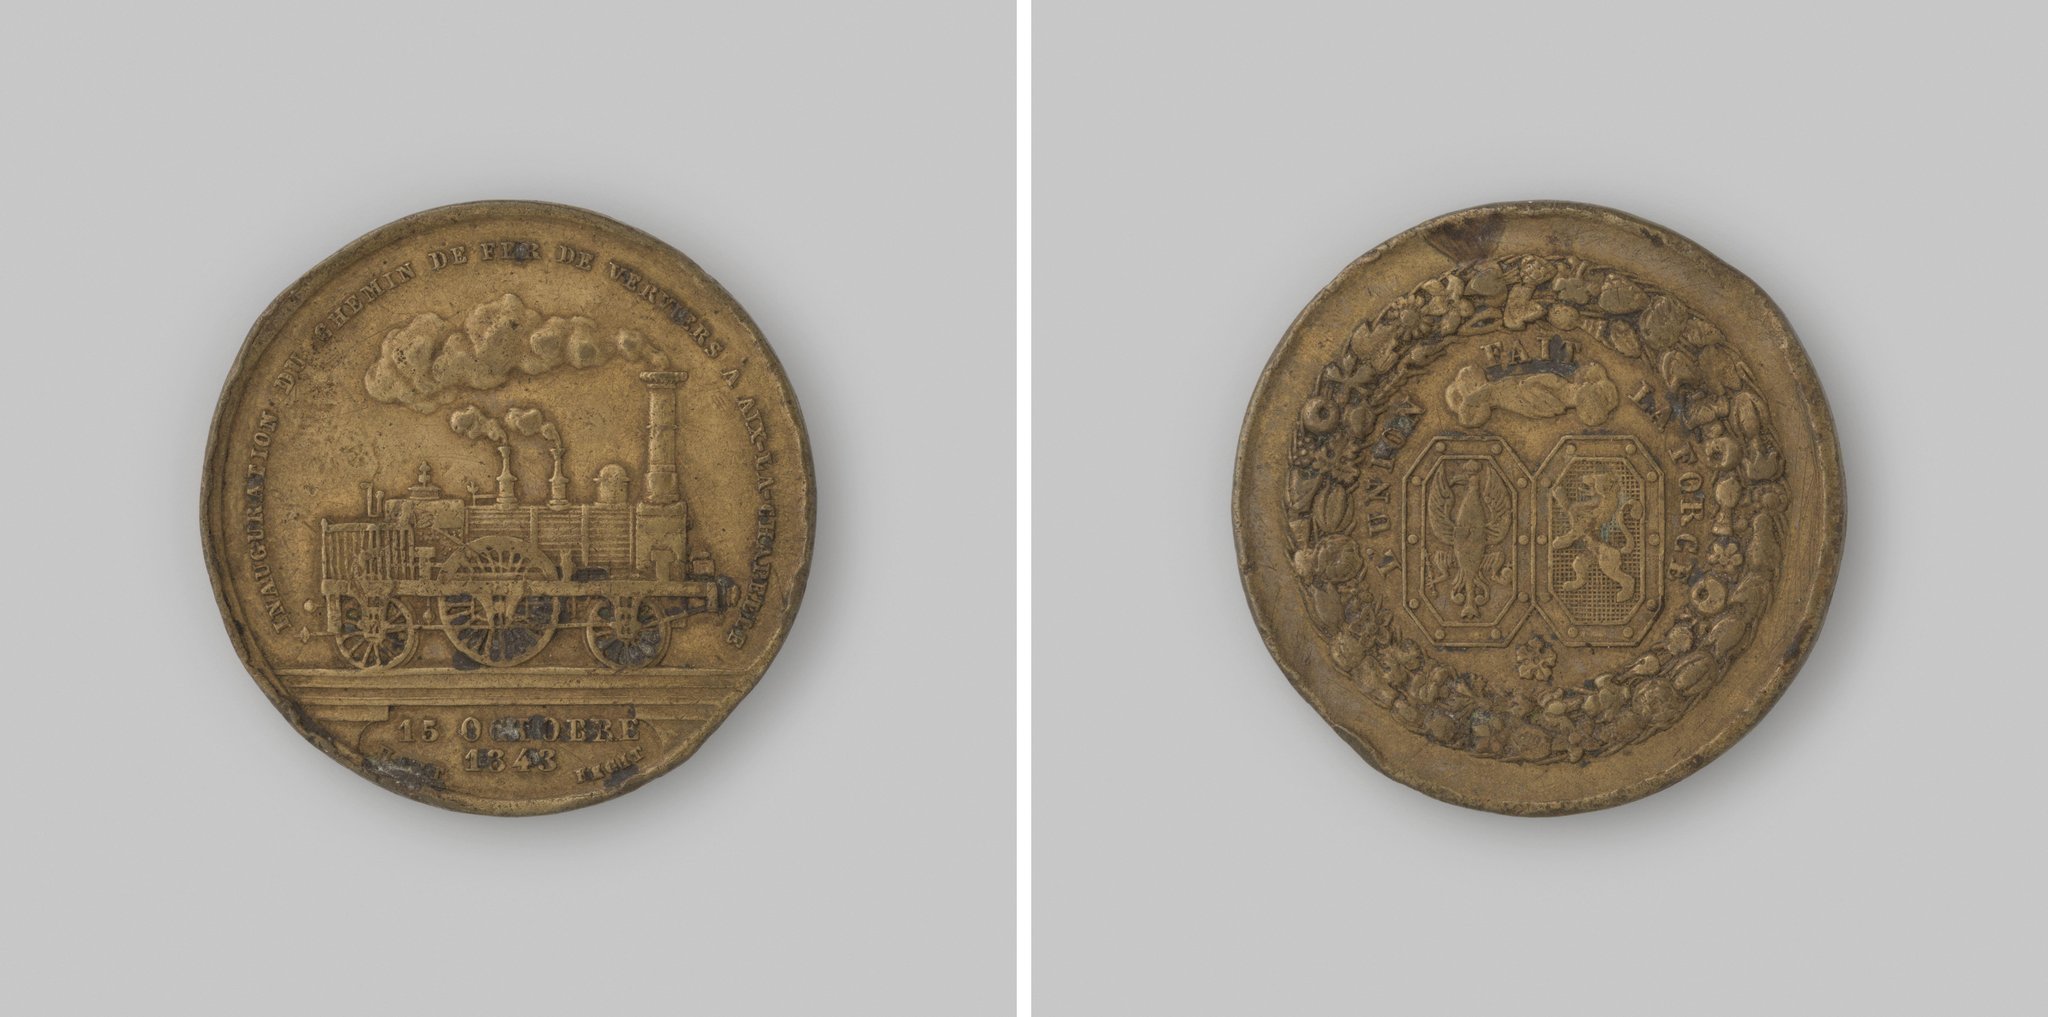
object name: history medal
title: Opening van de spoorweg Veviers-Aken 1843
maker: hart (stempelsnijder)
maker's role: die cutter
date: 1830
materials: brass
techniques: striking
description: Messing penning, op de voorzijde een locomotief naar rechts op een brug, met omschrift en afsnedetekst, op de keerzijde twee achthoekige wapenschilden onder ineengeslagen handen, met omschrift, binnen een bloemenkrans.